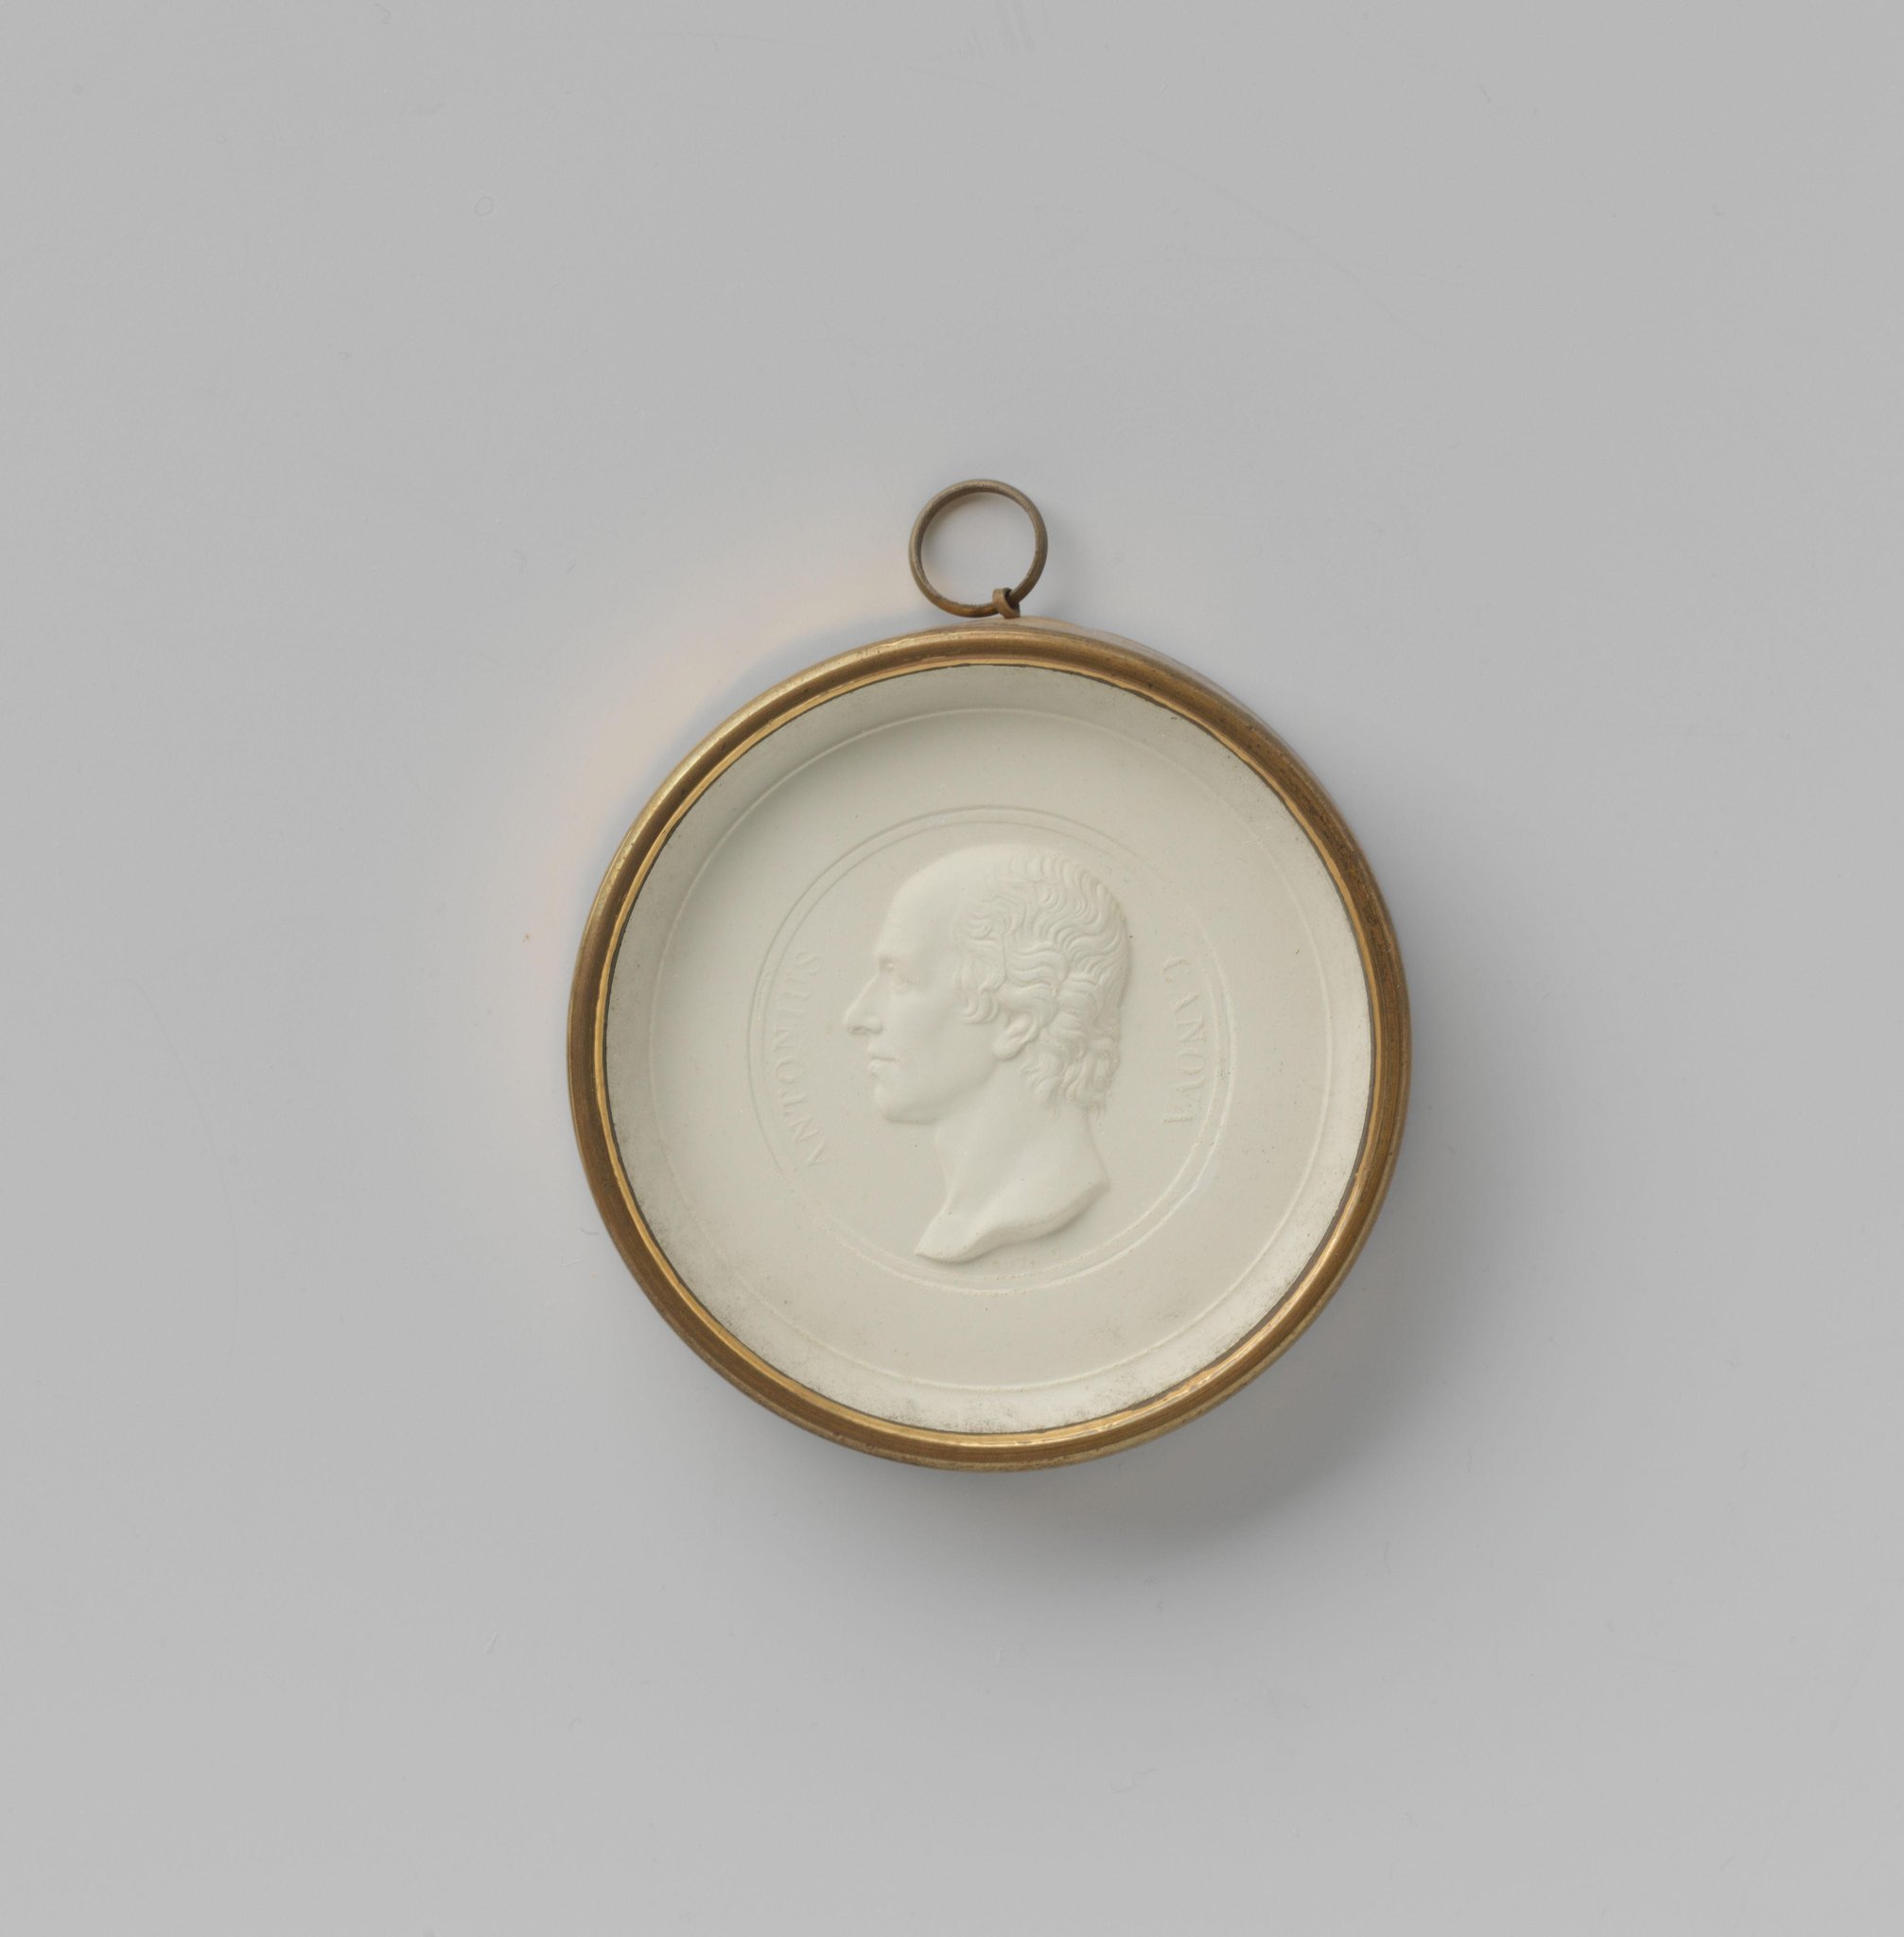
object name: locket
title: C. Secondat de Montesquieu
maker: gottfried eichler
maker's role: draughtsman, painter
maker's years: 1677-1757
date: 1817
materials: brass, glass, gypsum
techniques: casting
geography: berlin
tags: paris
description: Eenzijdig medaillon in messing ring achter glas aan draagoog en draagring. Voorzijde: borststuk man naar links binnen omschrift. Keerzijde: etiket met opschrift.